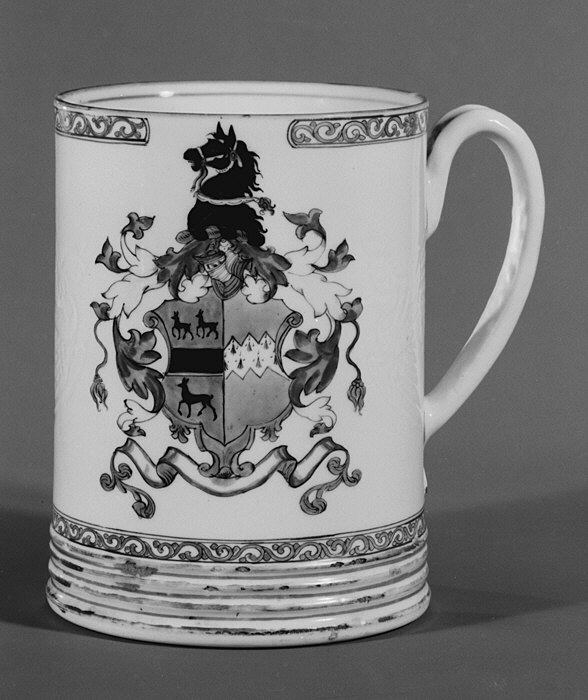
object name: mug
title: Mug (one of a pair)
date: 1720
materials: hard paste porcelain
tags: horses,coat of arms